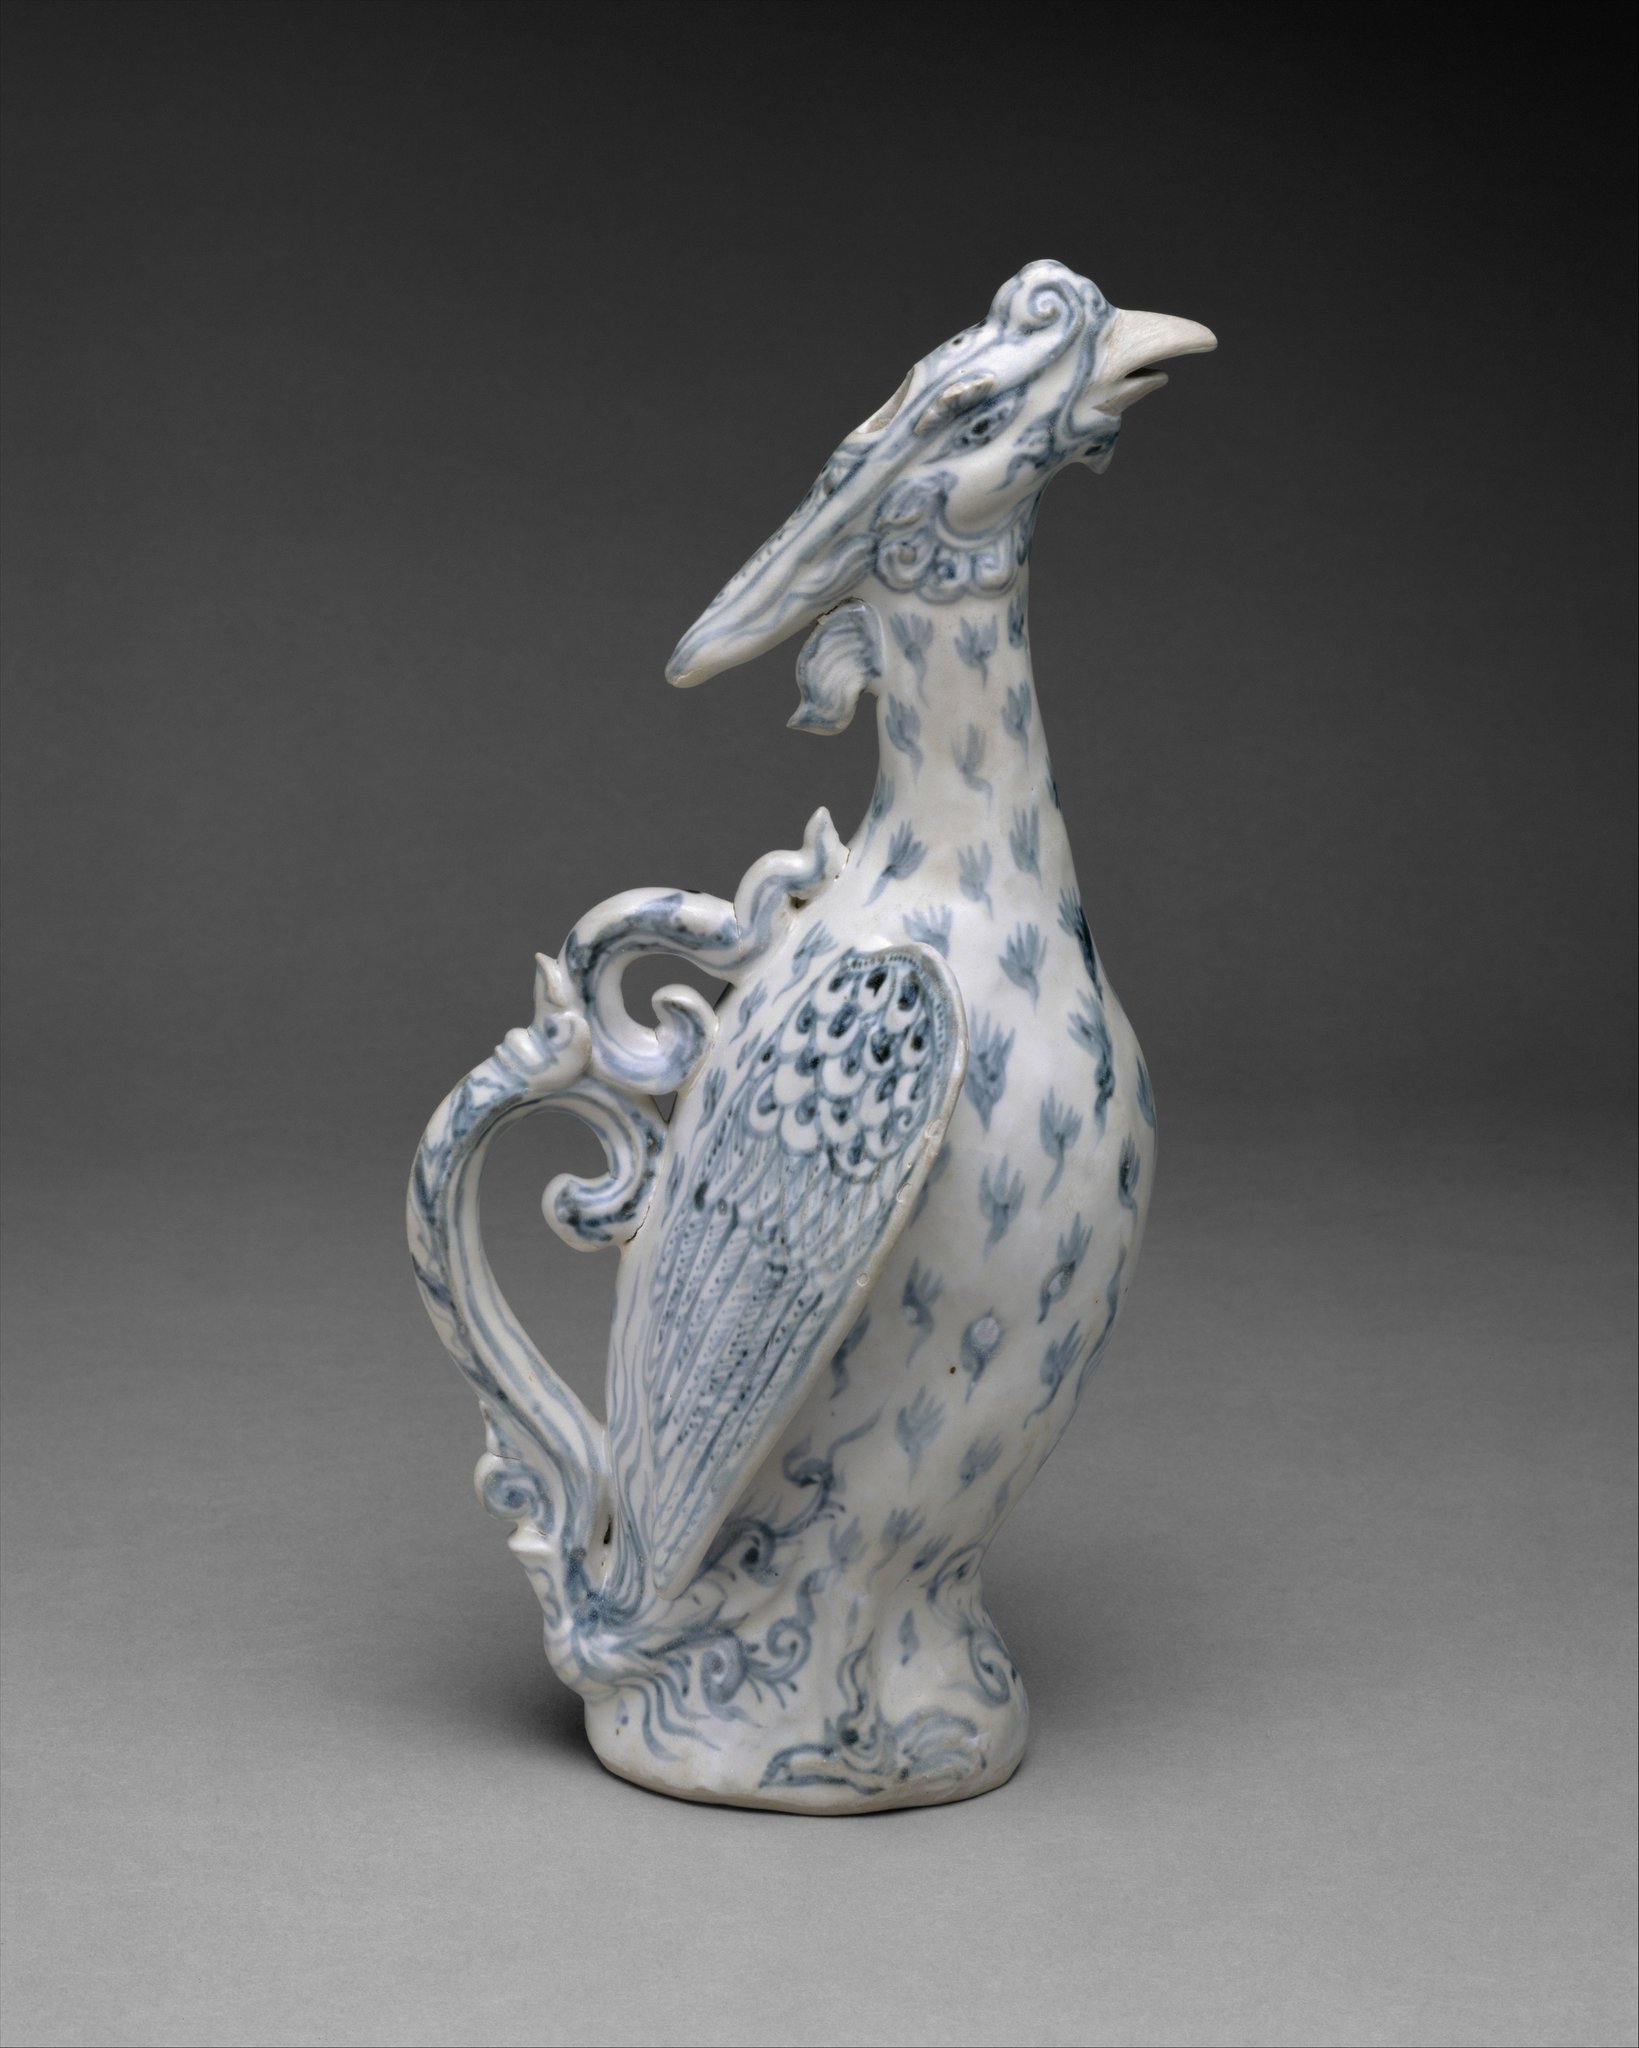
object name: ewer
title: Ewer in the Form of a Phoenix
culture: vietnamese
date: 1401-1600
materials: cobalt, stoneware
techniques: underglaze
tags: phoenix